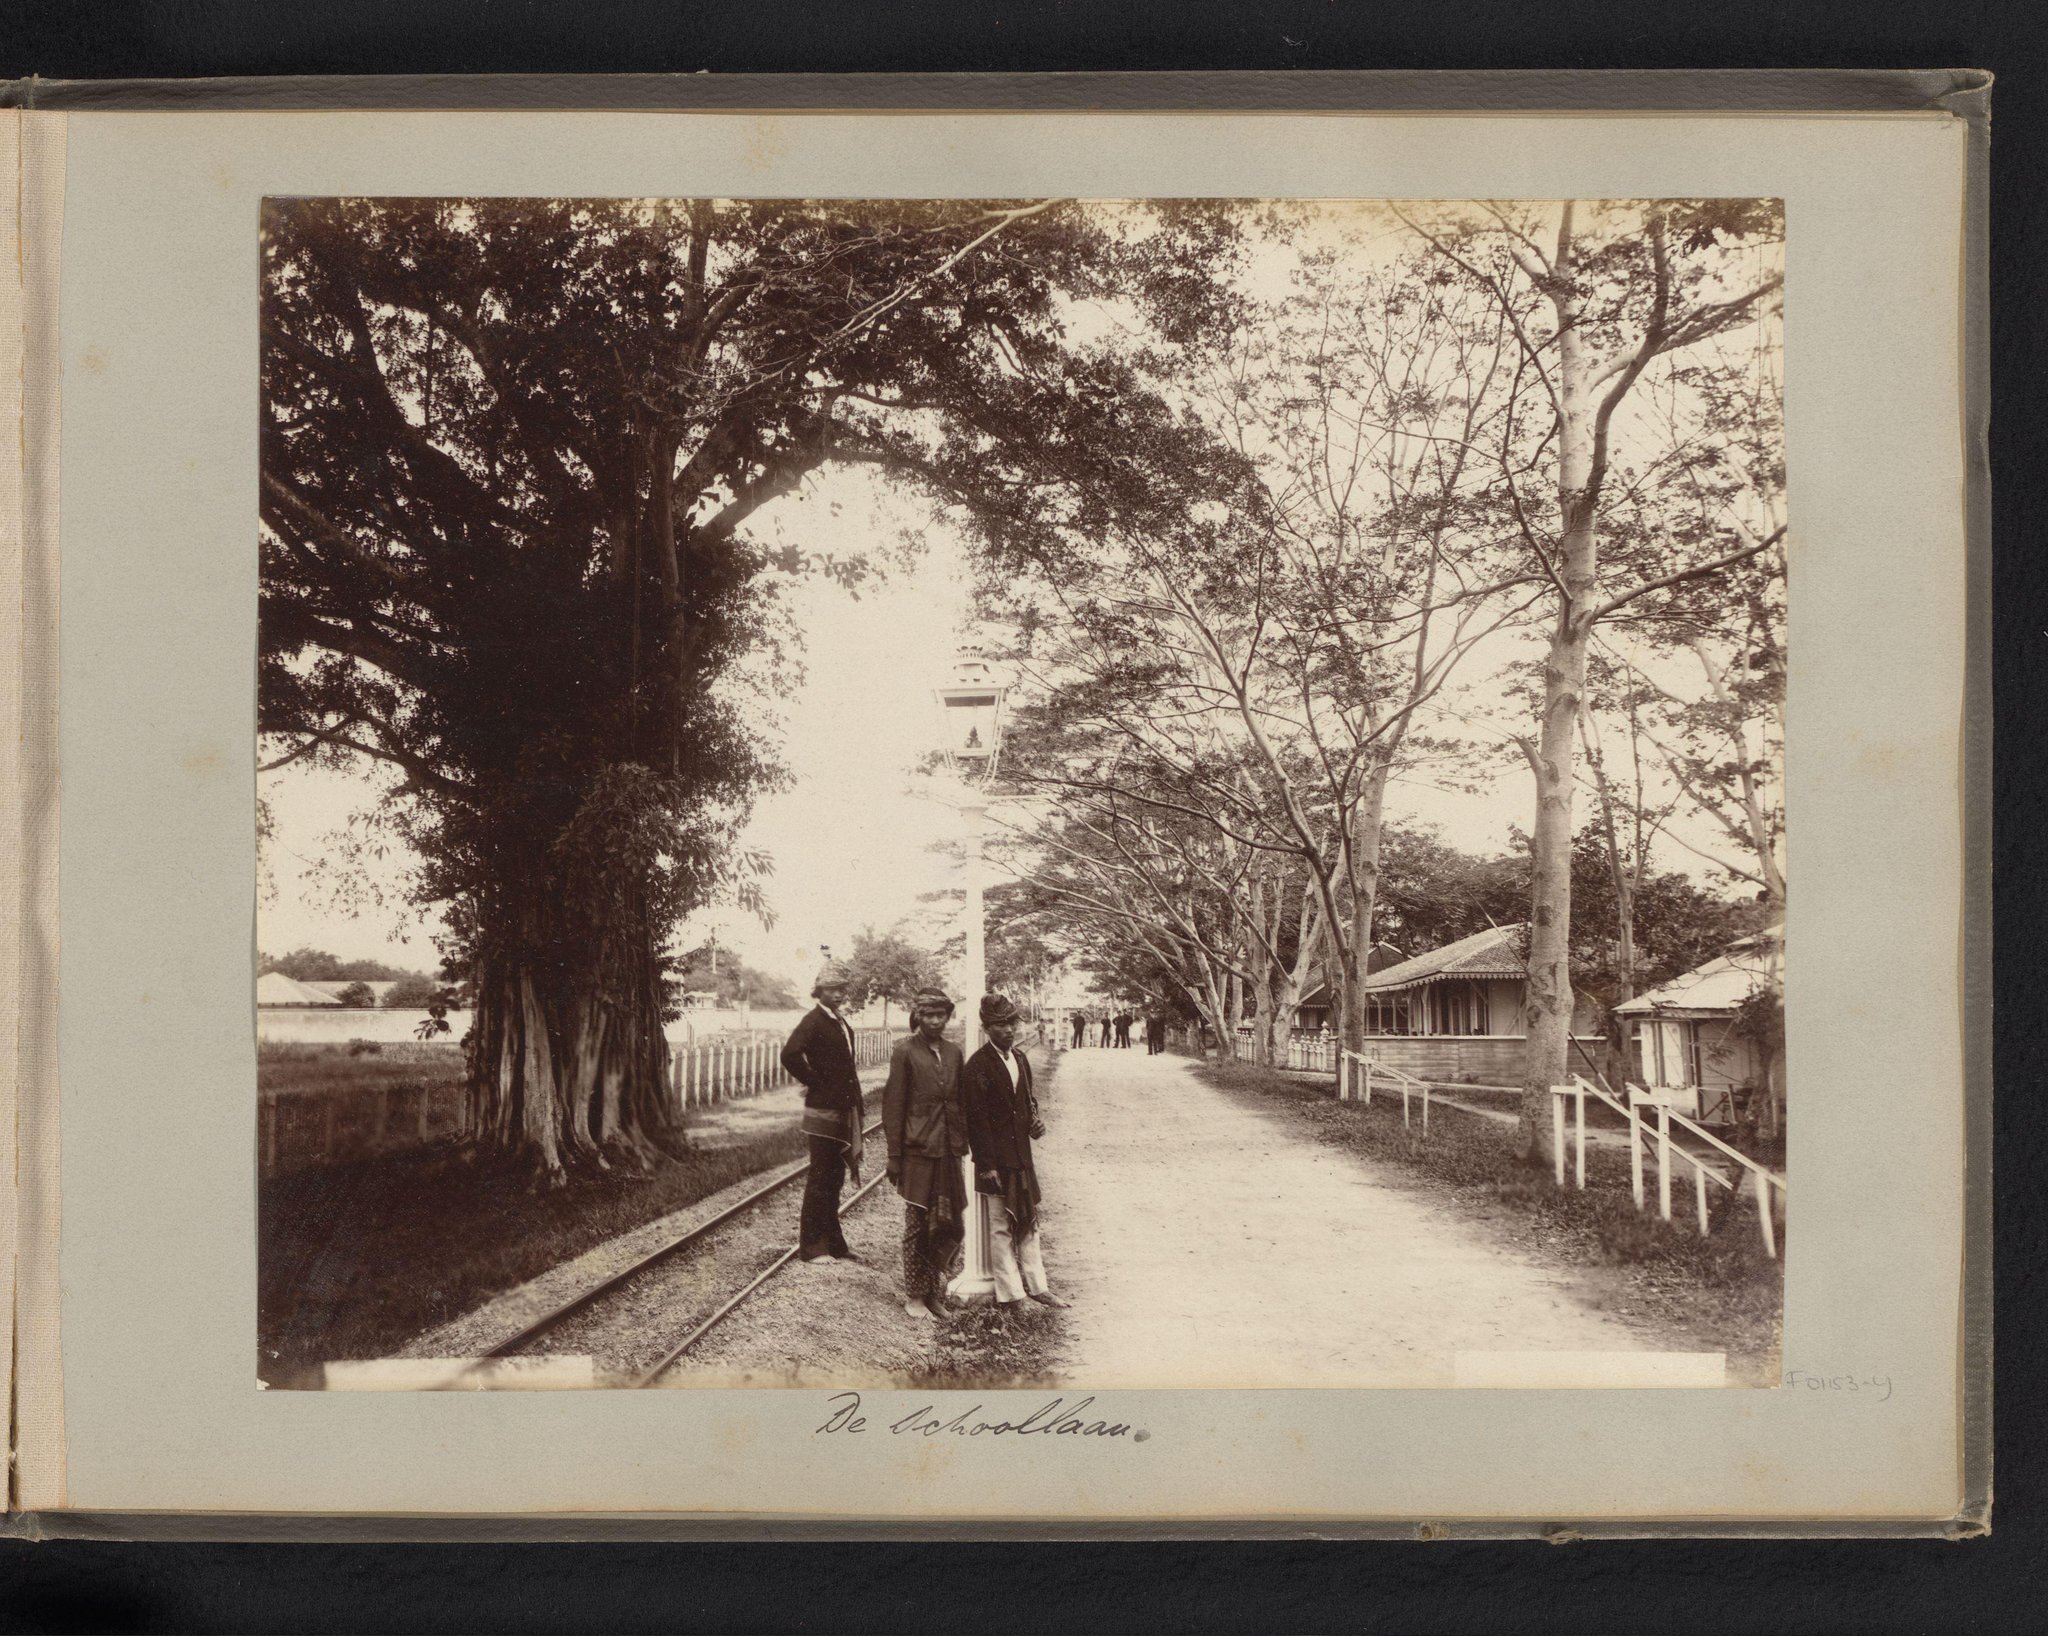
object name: photograph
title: De Schoollaan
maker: a. kaulfuss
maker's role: fotograaf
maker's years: 1861-1909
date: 1891-1894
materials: photographic support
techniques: albumen print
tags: asiatic races and peoples (indonesians), youth, adolescent